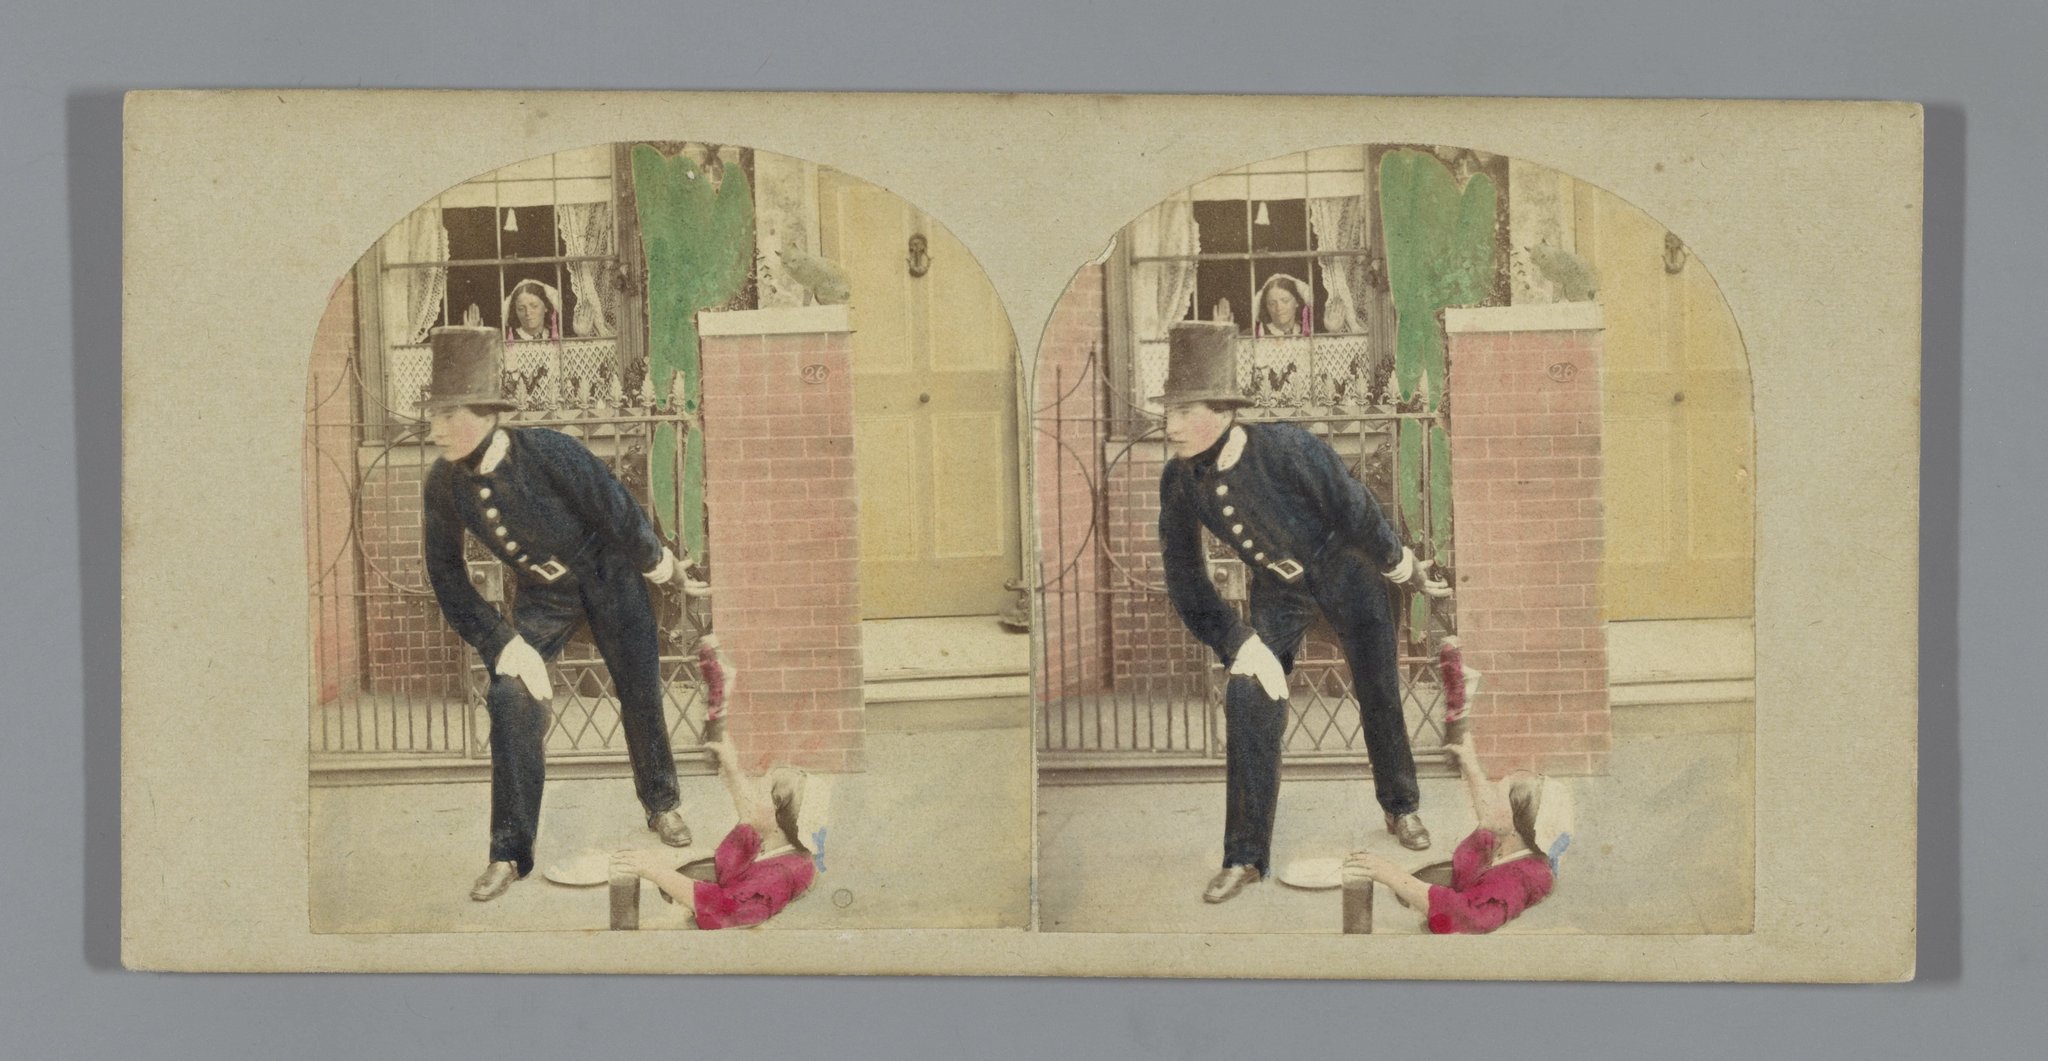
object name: stereograph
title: Vrouw zwaait naar een man vanuit een put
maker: Anonymous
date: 1852-1863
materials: cardboard, paper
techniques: albumen print, hand coloring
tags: parts (of house or building), adult woman, adult man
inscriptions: number: ‘80’